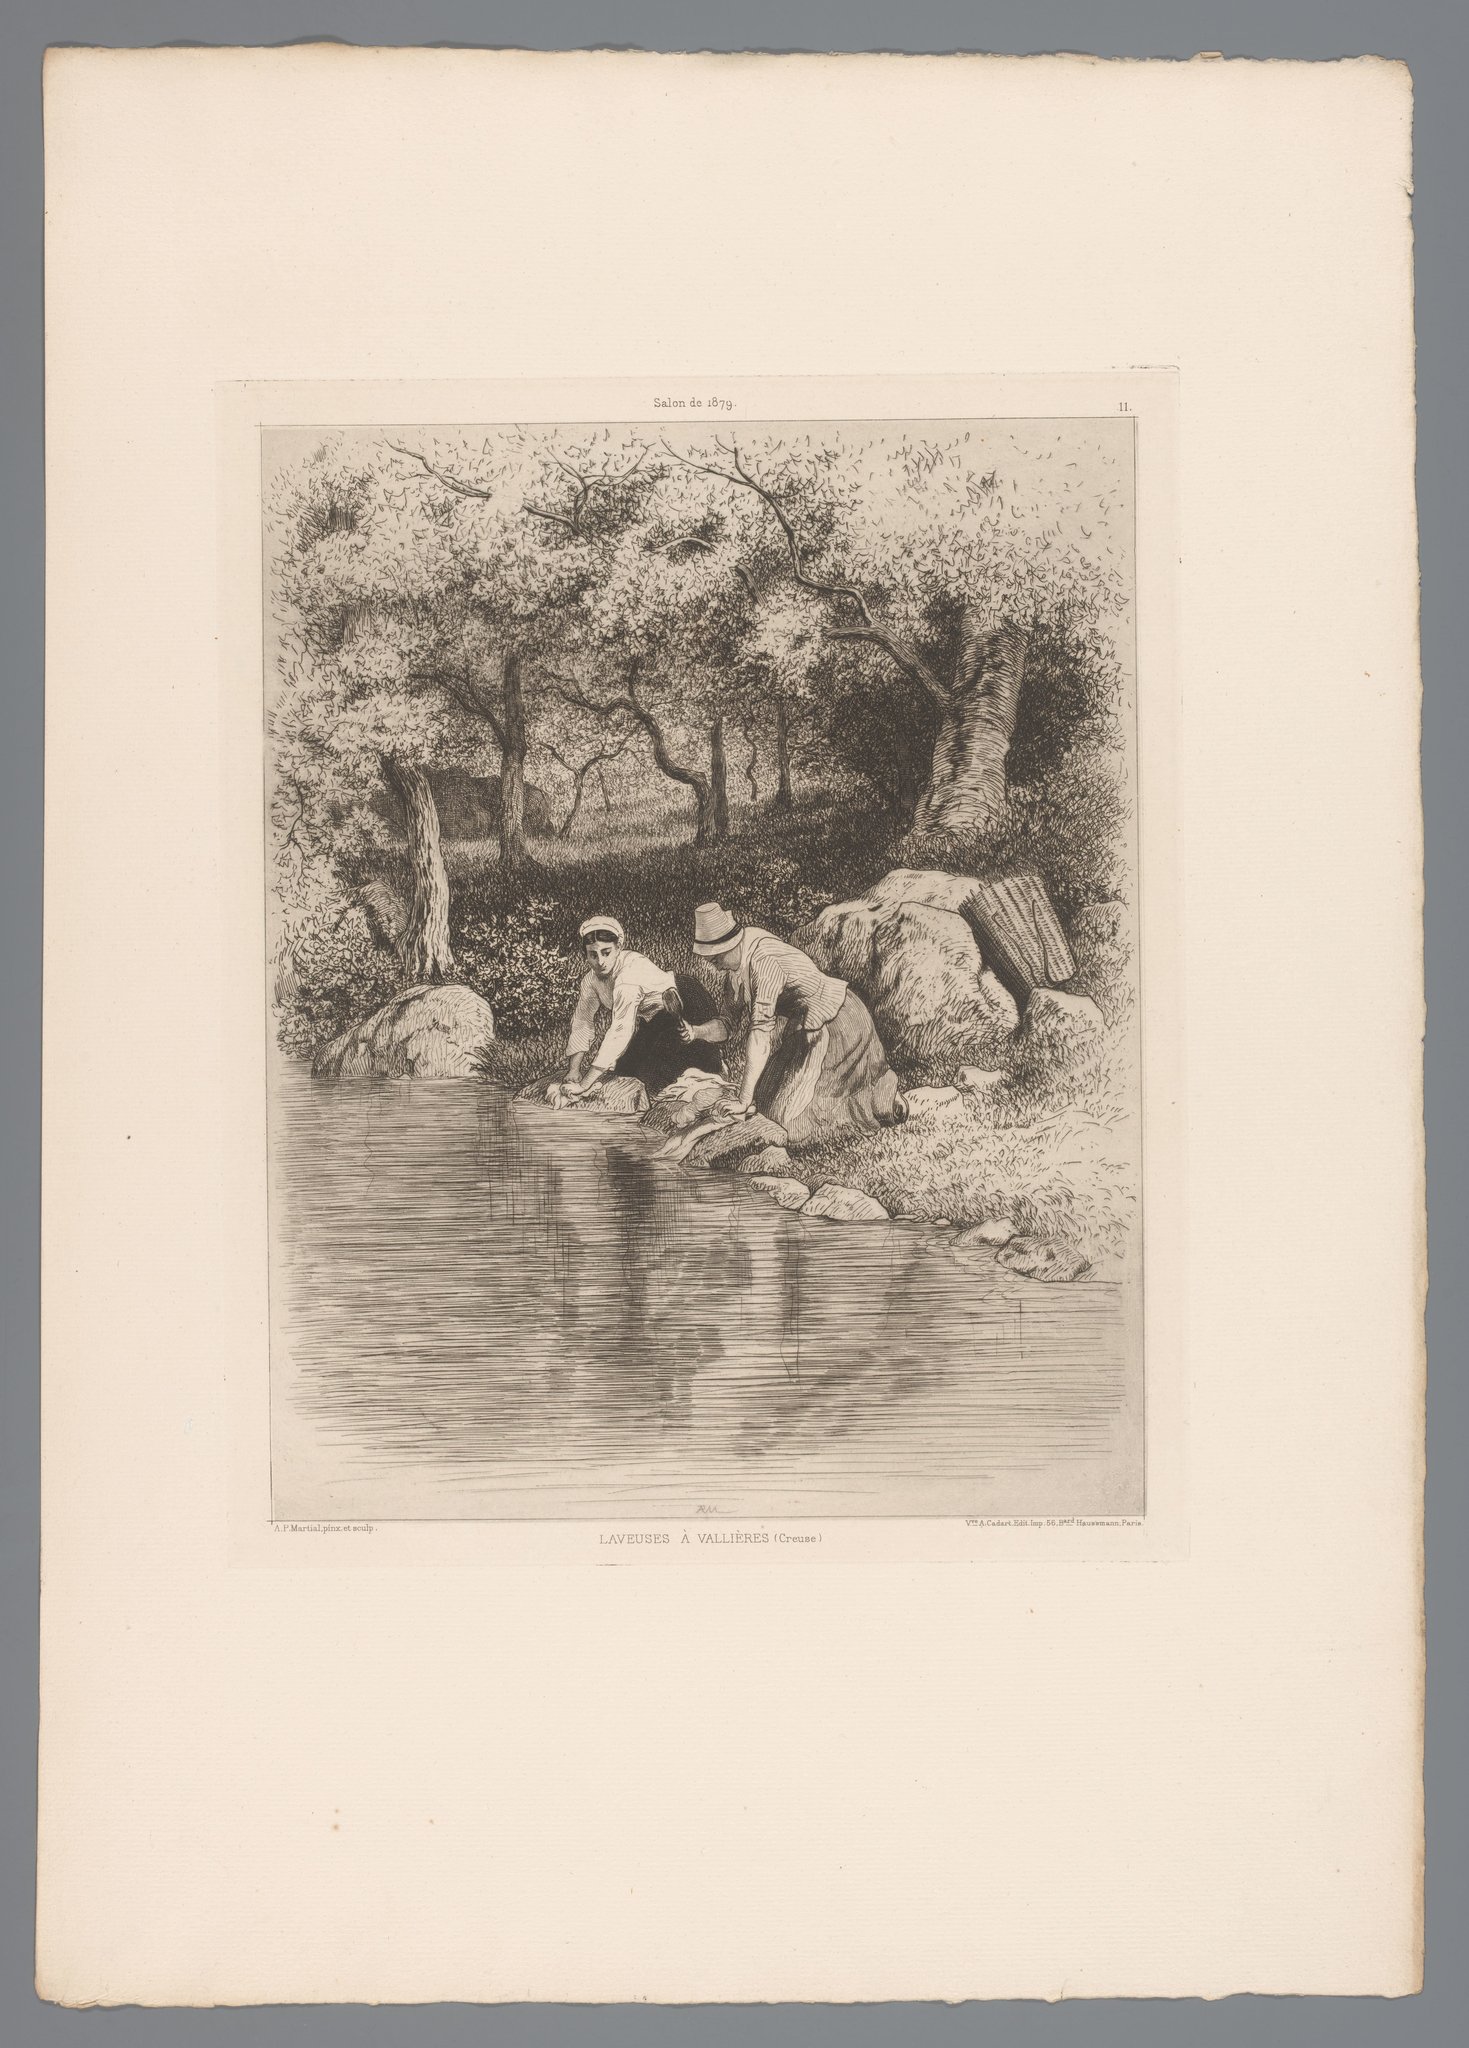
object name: print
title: Franse etsen uit 1880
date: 1880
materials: paper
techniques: drypoint, etching, intaglio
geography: paris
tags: landscapes with waters, waterscapes, seascapes (in the temperate zone), laundering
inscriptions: collector's mark: Lugt 2228, collector's mark: Lugt 2760, collector's mark: ‘AFE v S’, watermark